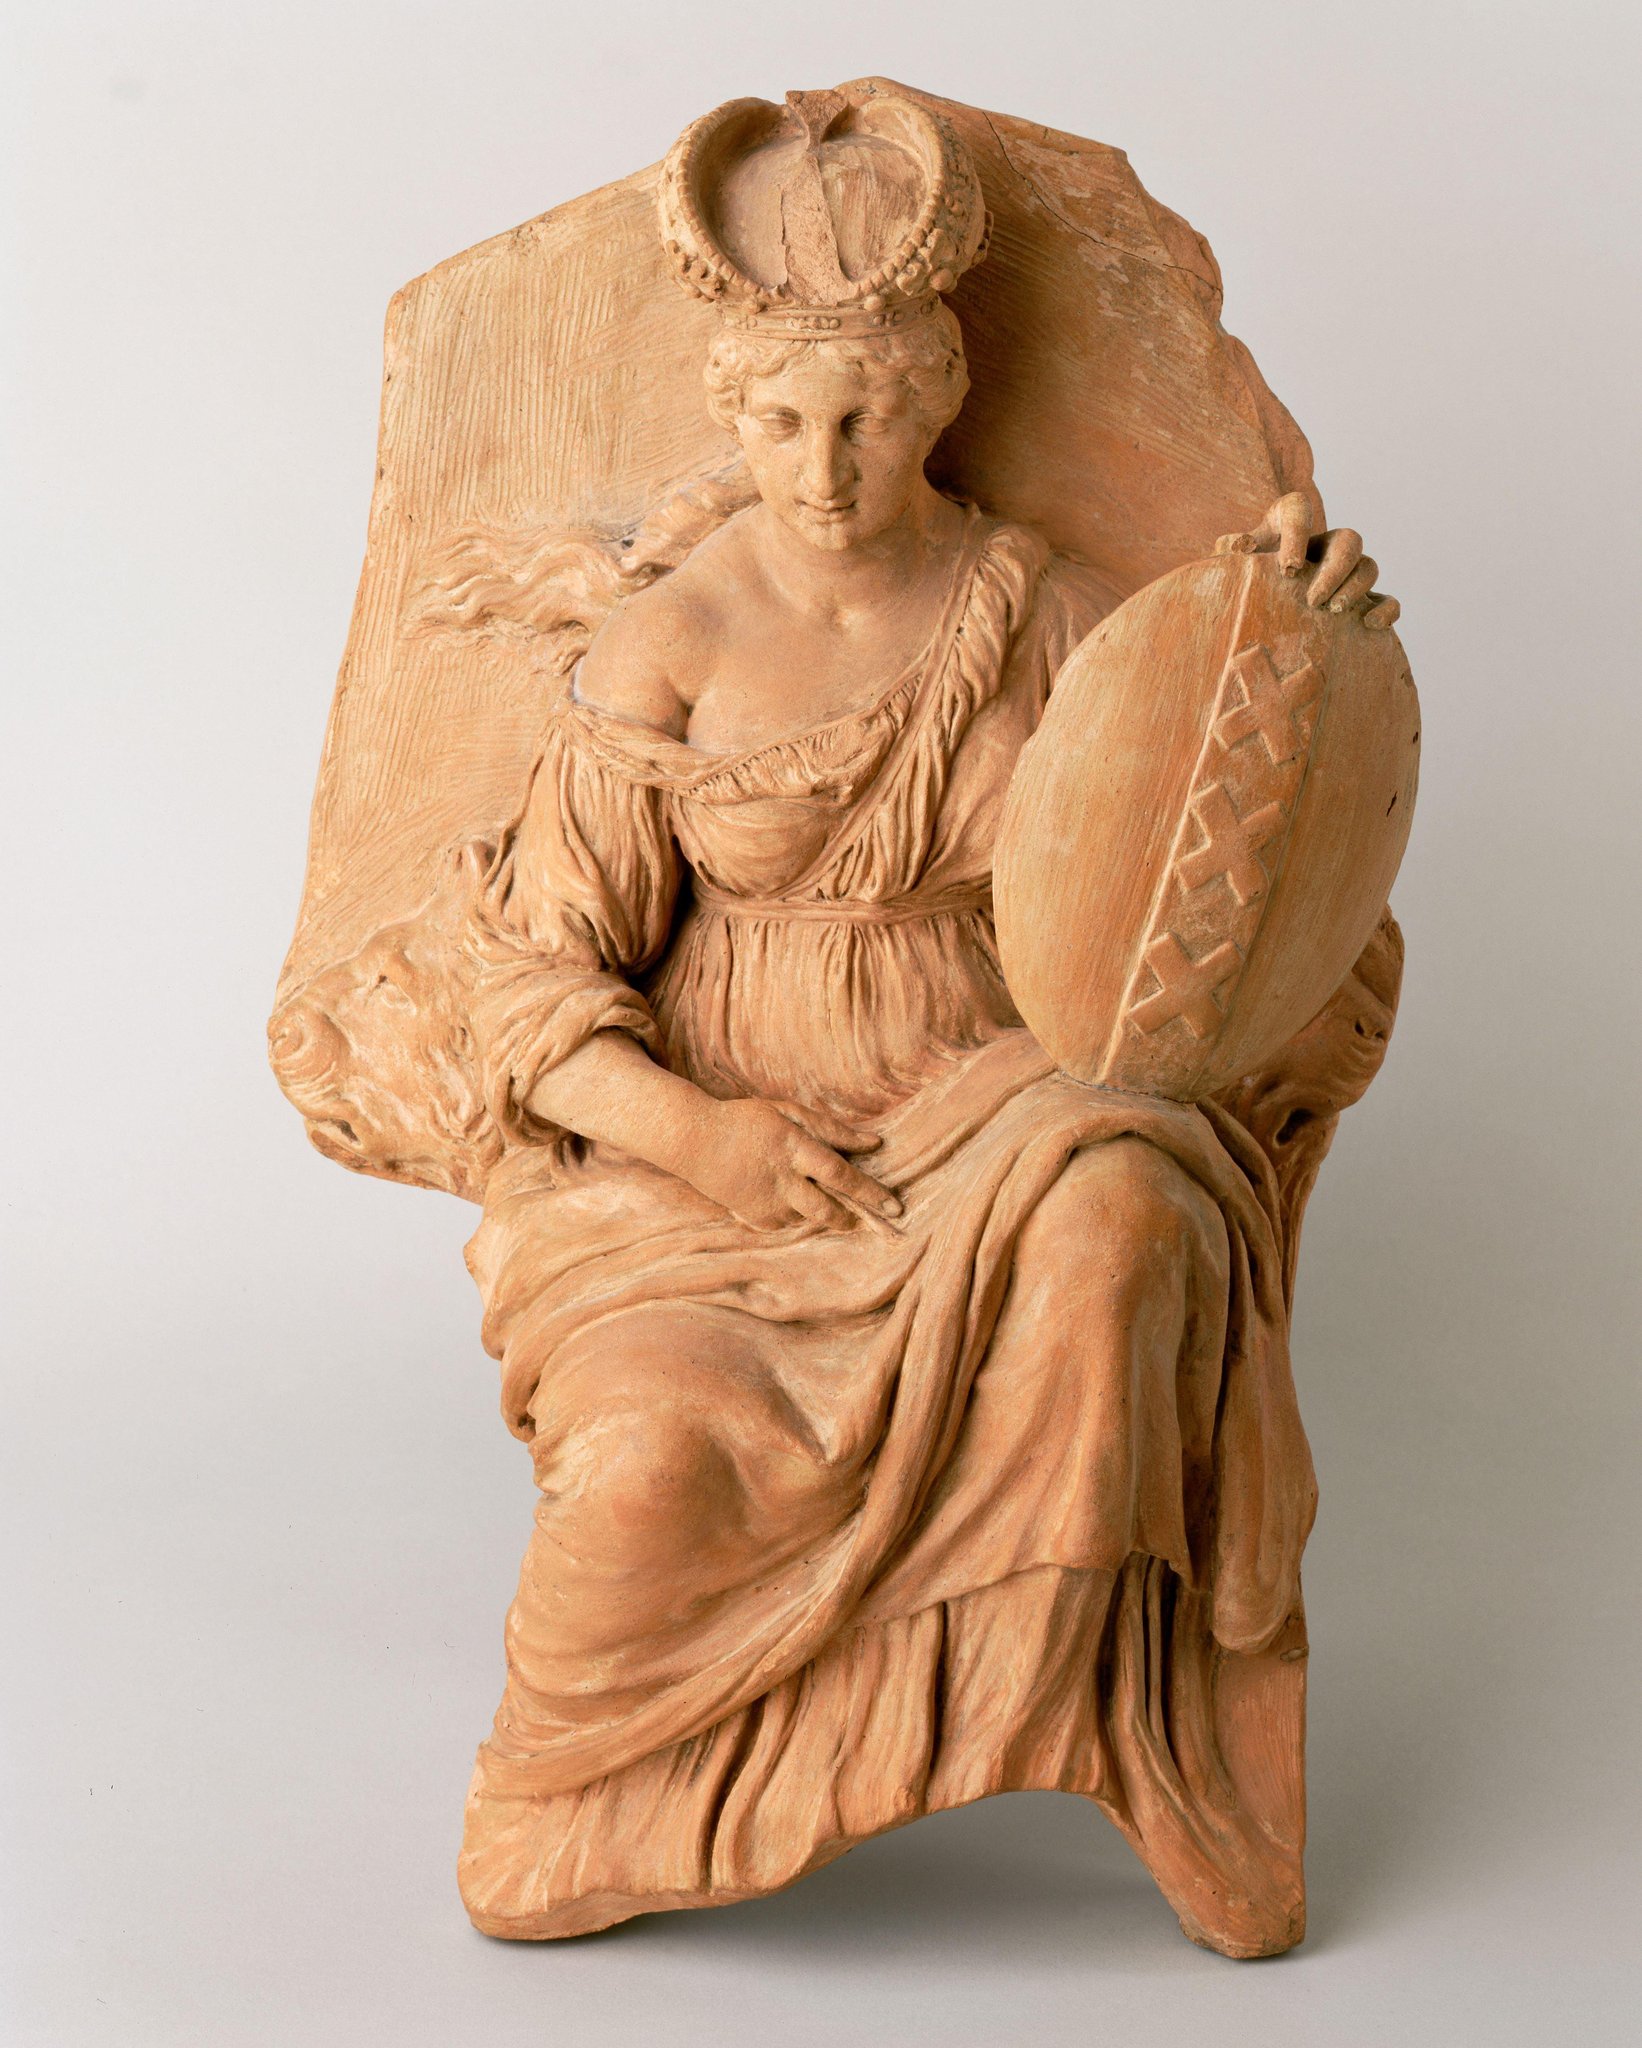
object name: model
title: The Maid of Amsterdam, Part of a Model for the East Tympanum of the Amsterdam Town Hall (now Royal Palace) at Dam Square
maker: artus quellinus (i)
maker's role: draughtsman, print maker, sculptor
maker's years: 1609-1668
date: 1650-1653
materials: terracotta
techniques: modeling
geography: amsterdam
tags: personification of a city, town-patron(ess), amsterdam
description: Artus Quellinus (1609 - 1668). Naiads and Tritons. Terracotta. Amsterdam, c. 1651. On loan from the City of Amsterdam.